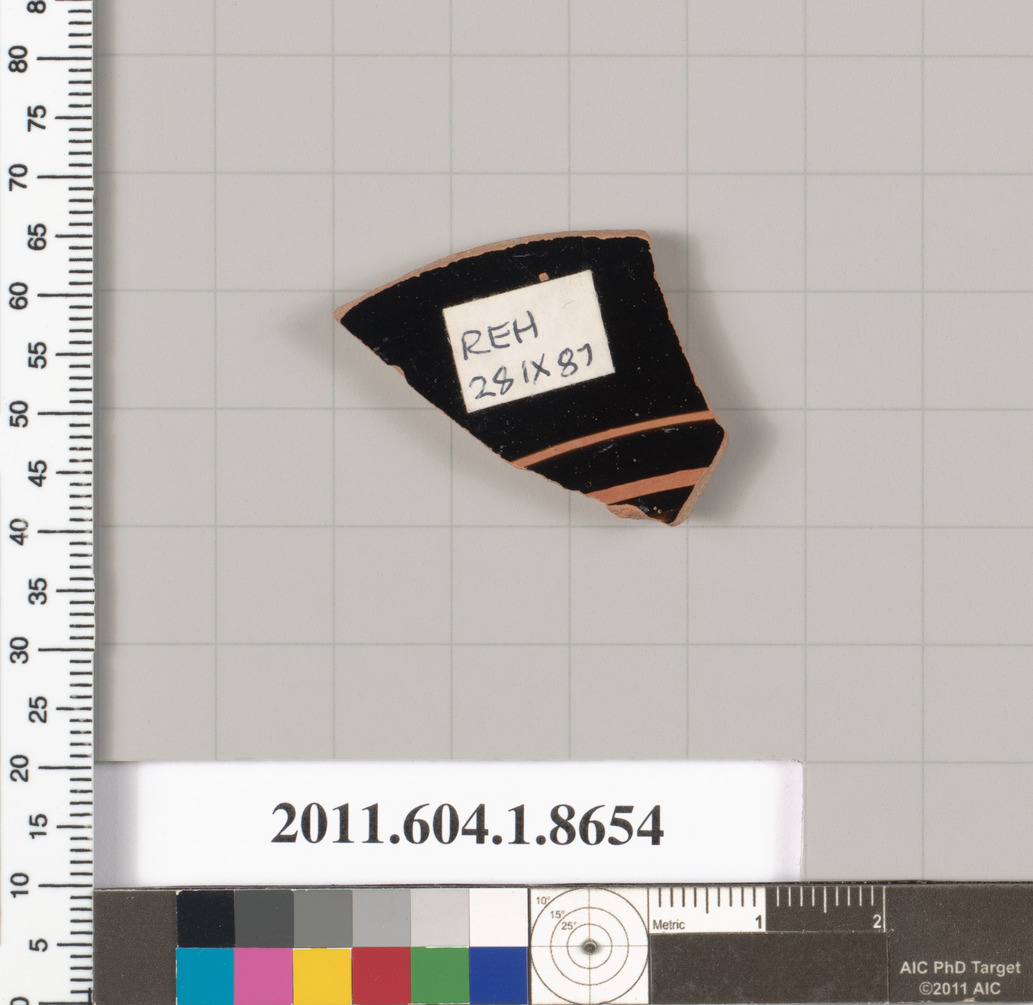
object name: kylix fragment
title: Terracotta rim fragment of a stemless? kylix (drinking cup)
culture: greek, attic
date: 460-450 BCE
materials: terracotta